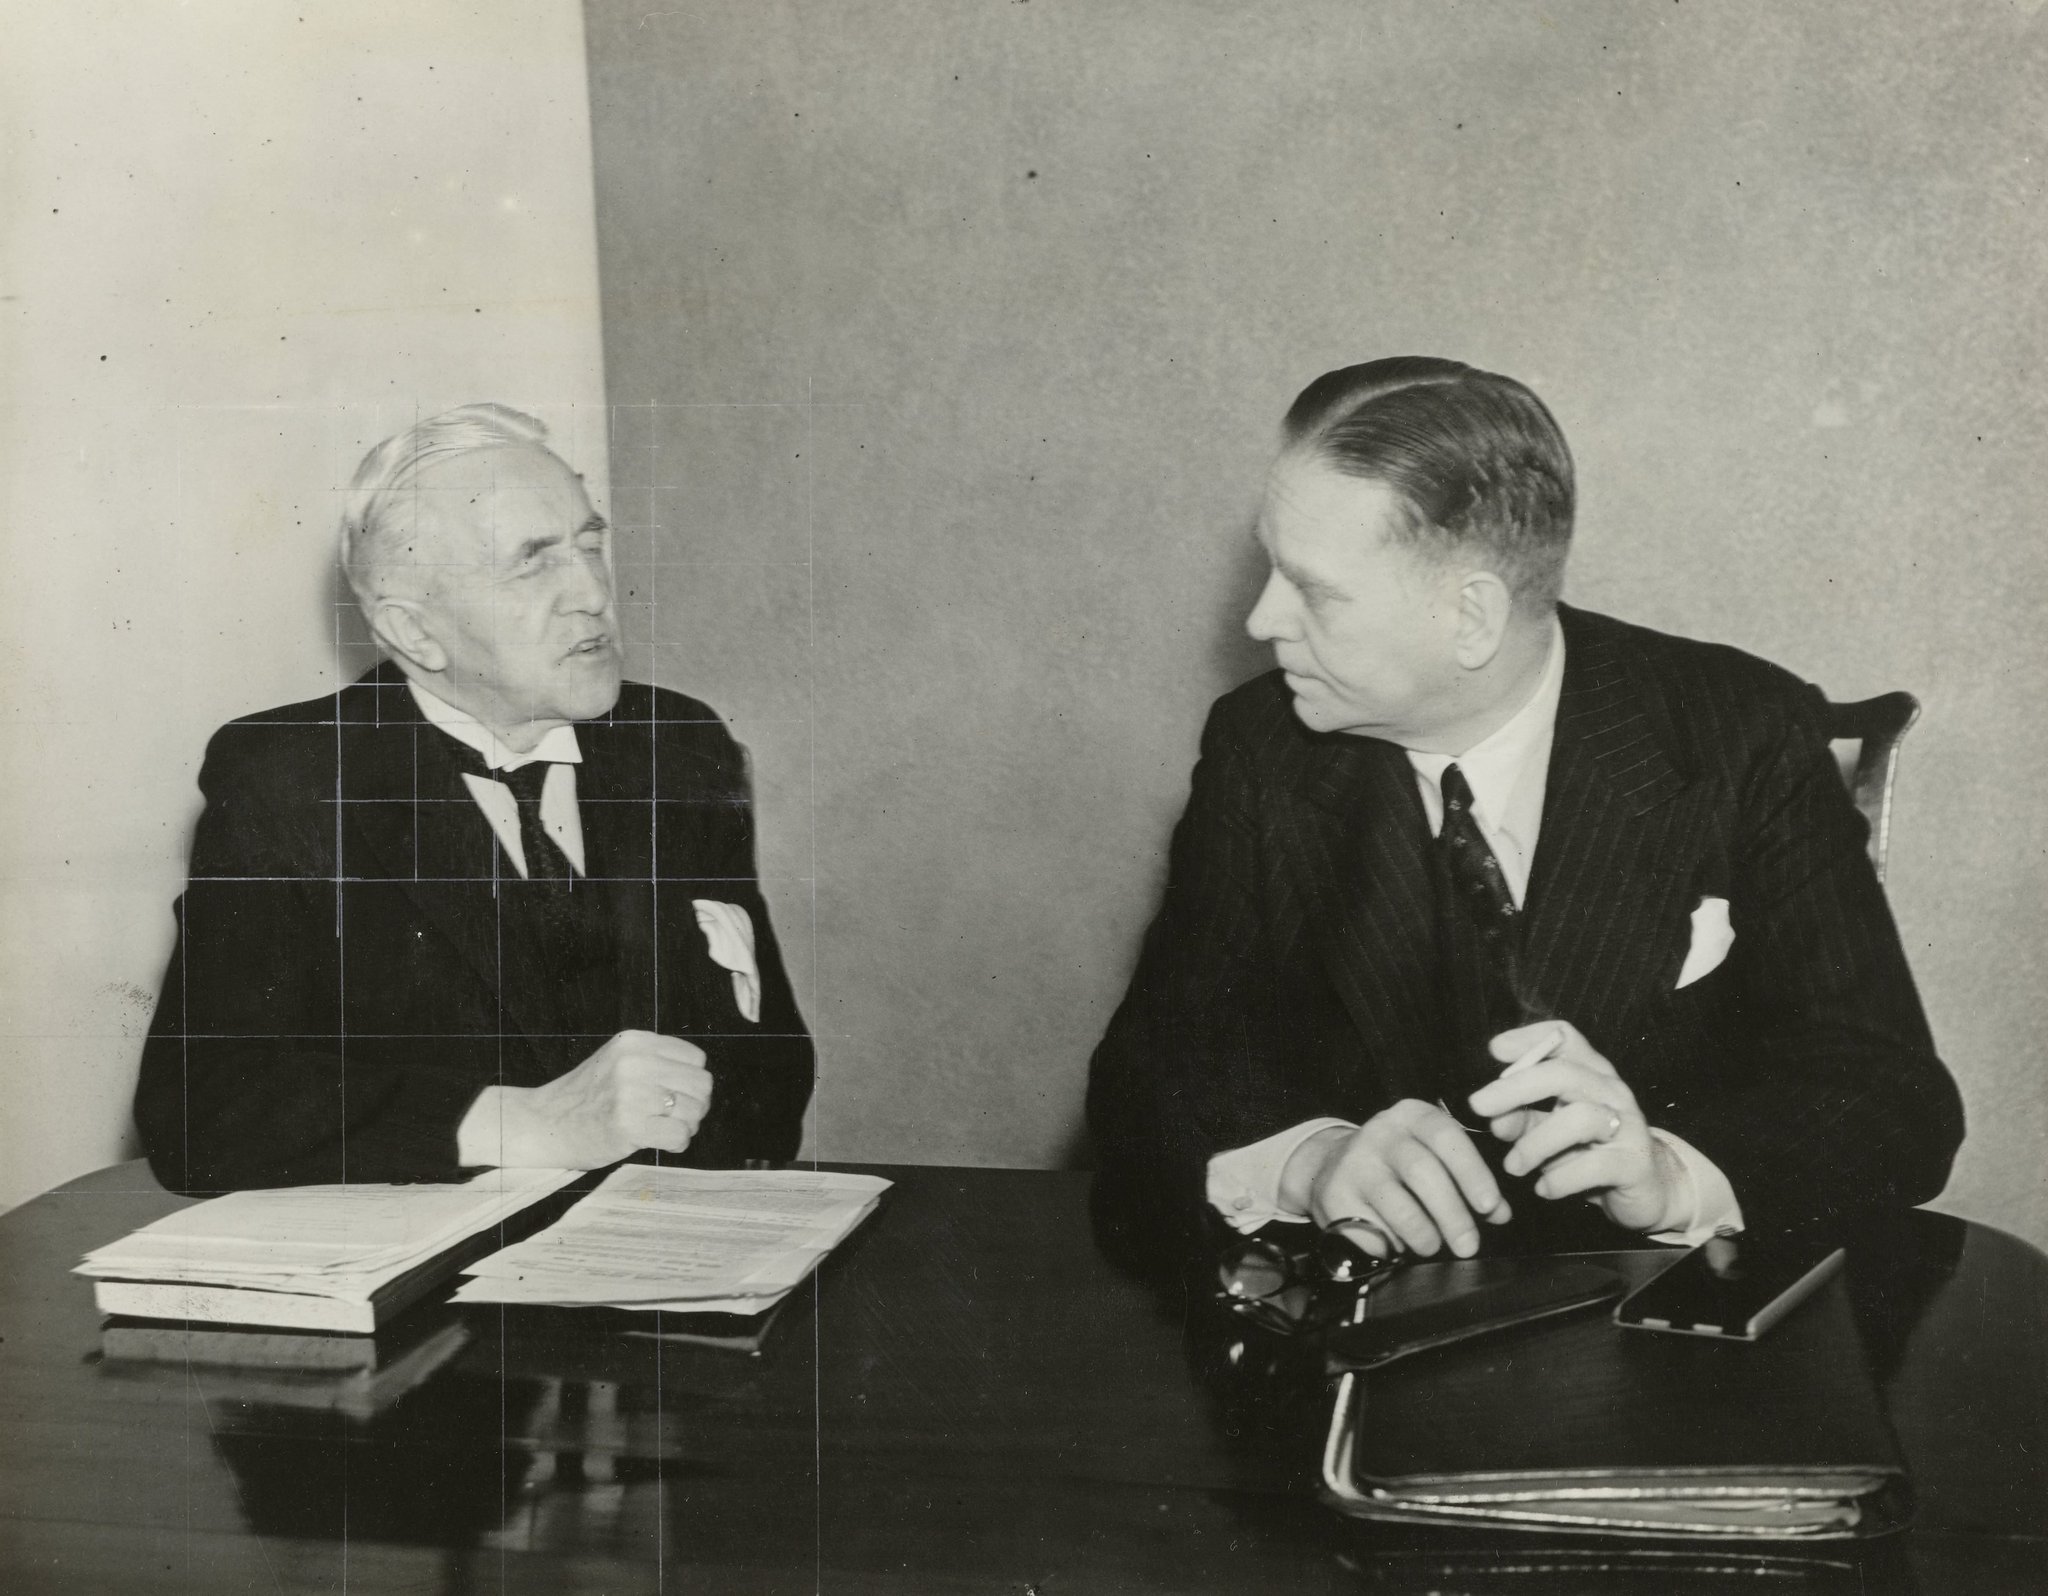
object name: photograph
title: Ministers Bolkestein en Kerstens in gesprek.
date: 1940-1945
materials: photographic support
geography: london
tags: amsterdam, london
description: Minister Gerrit Bolkestein (1871-1956) van onderwijs in gesprek met minister Piet Kerstens (1896-1958) van handel, nijverheid en scheepvaart.Het lijnennet over Minister Bolkestein is aangebracht door Cor Visser voor zijn tekening van het oorlogskabinet Gerbrandy